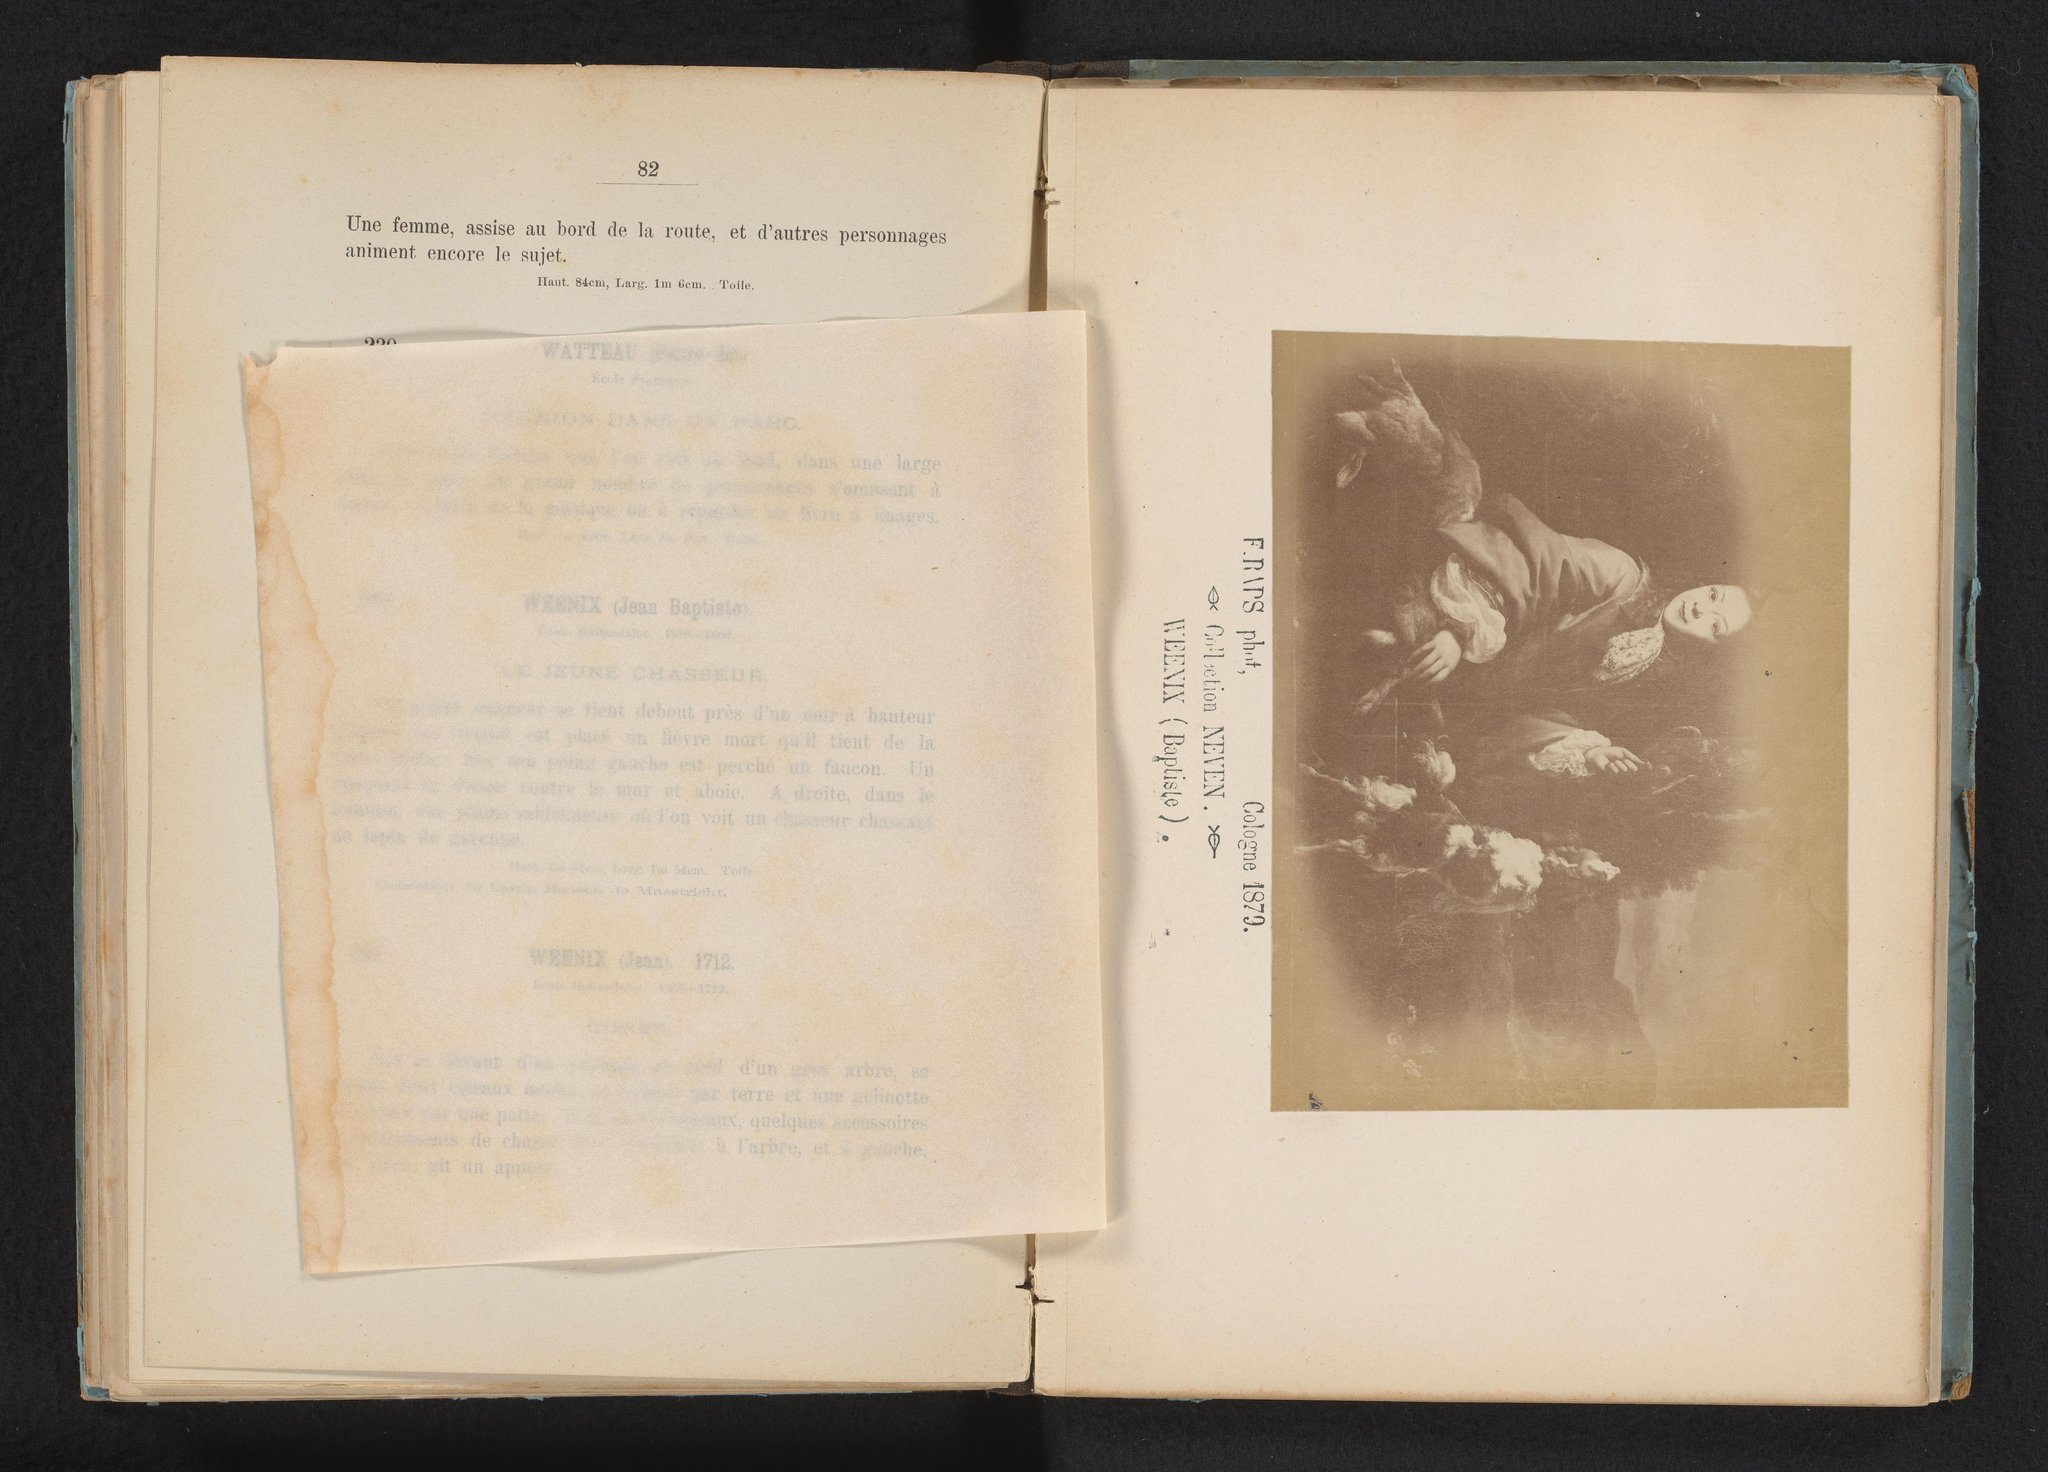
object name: page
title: Fotoreproductie van een schilderij van een jonge jager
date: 1879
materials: photographic support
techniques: albumen print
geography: cologne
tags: predatory birds: falcon, hunter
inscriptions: inscription: ‘Collection NEVEN/ Weenix (Baptiste).’